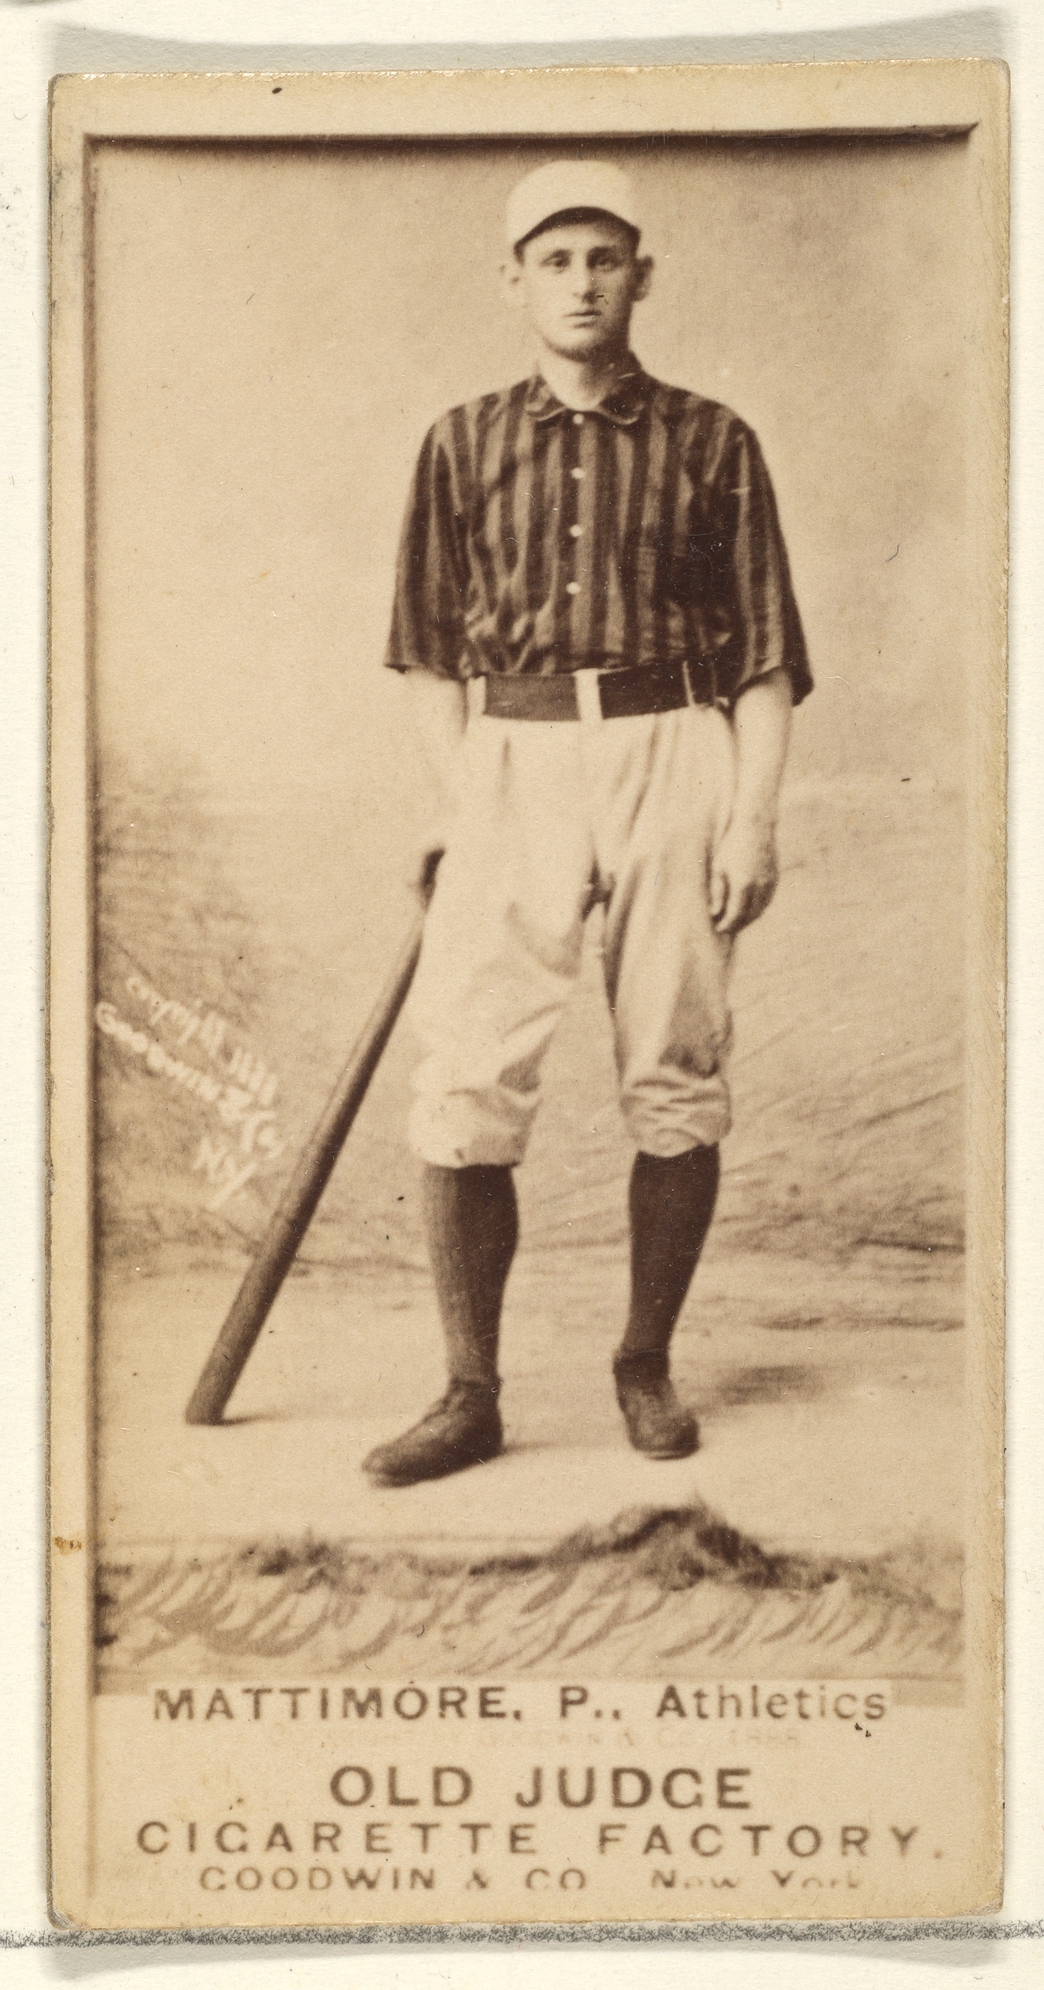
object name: baseball card, photograph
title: Mattimore, Pitcher, Philadelphia Athletics, from the Old Judge series (N172) for Old Judge Cigarettes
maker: goodwin & company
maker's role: publisher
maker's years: 1850-1950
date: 1888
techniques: albumen silver print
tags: men,portraits,baseball,athletes